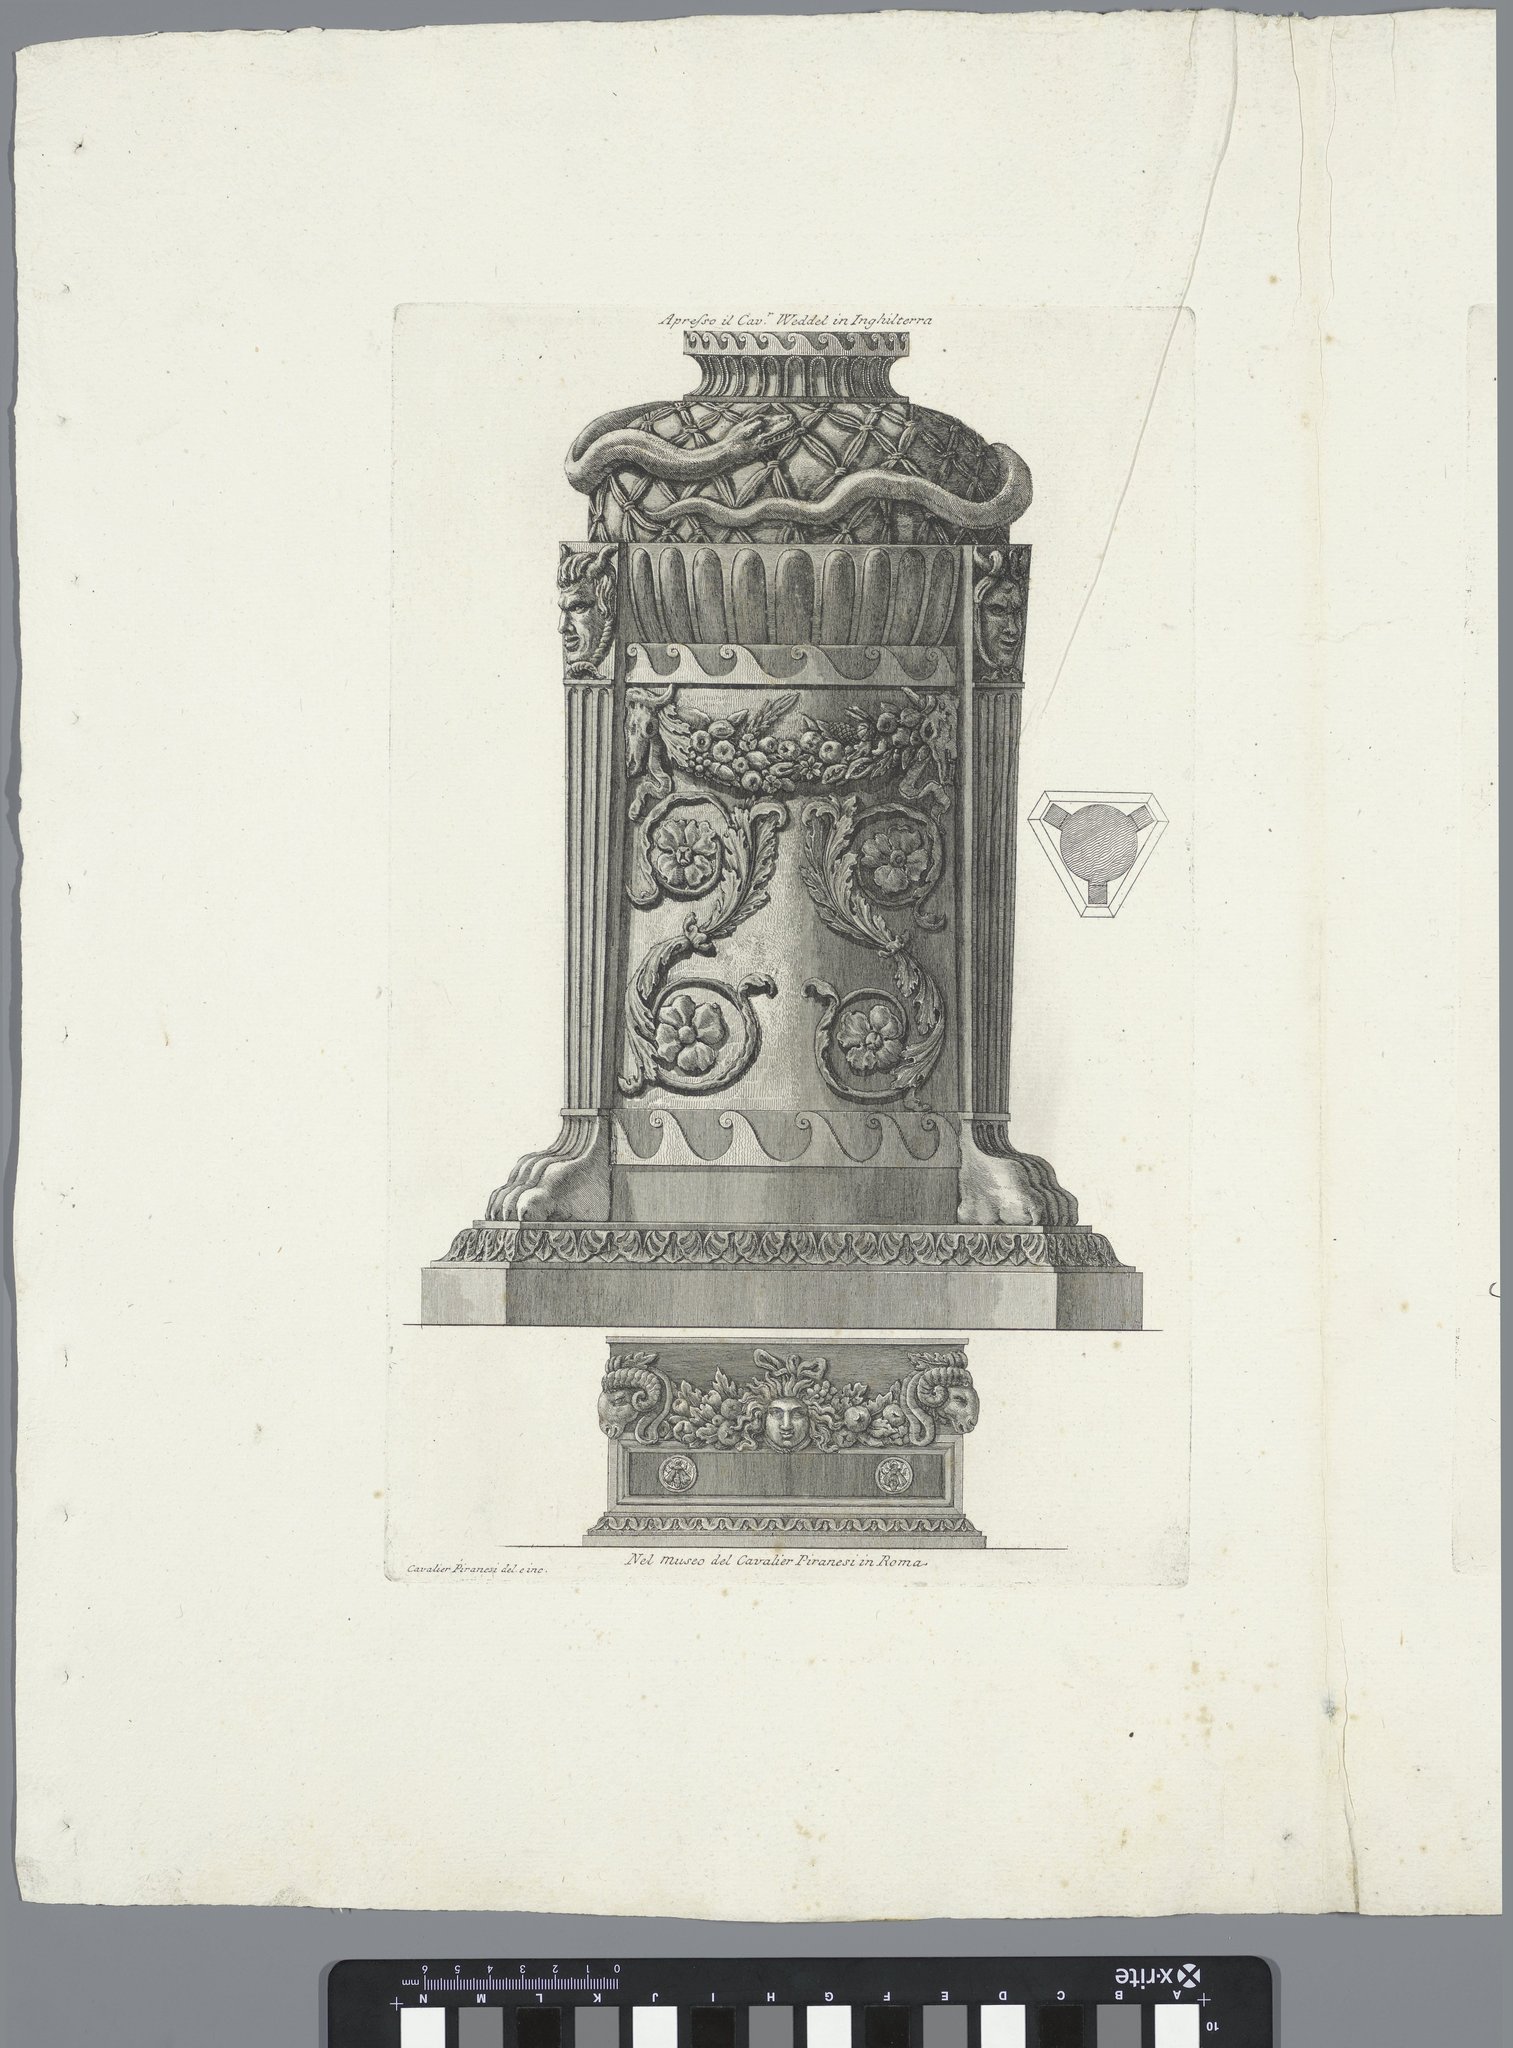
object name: print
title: Vazen, kandelaars, grafstenen, sarcofagen, tripods, lampen en ornamenten ontworpen en gegraveerd door Giovanni Battista Piranesi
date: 1778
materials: paper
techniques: etching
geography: rome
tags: tripod, vase ~ ornament, serpent ouroboros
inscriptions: collector's mark: Lugt 2228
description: Blad met twee voorstellingen van een antieke tripod en een vaas. Links: een antieke tripod met een ouroborus, maskers en een guirlande. Rechts een bovenaanzicht. Tekst boven en onder voorstelling. Rechts: een antieke vaas met putti en guirlandes. Tekst en verklarende letters boven voorstelling. Opdracht in ondermarge.